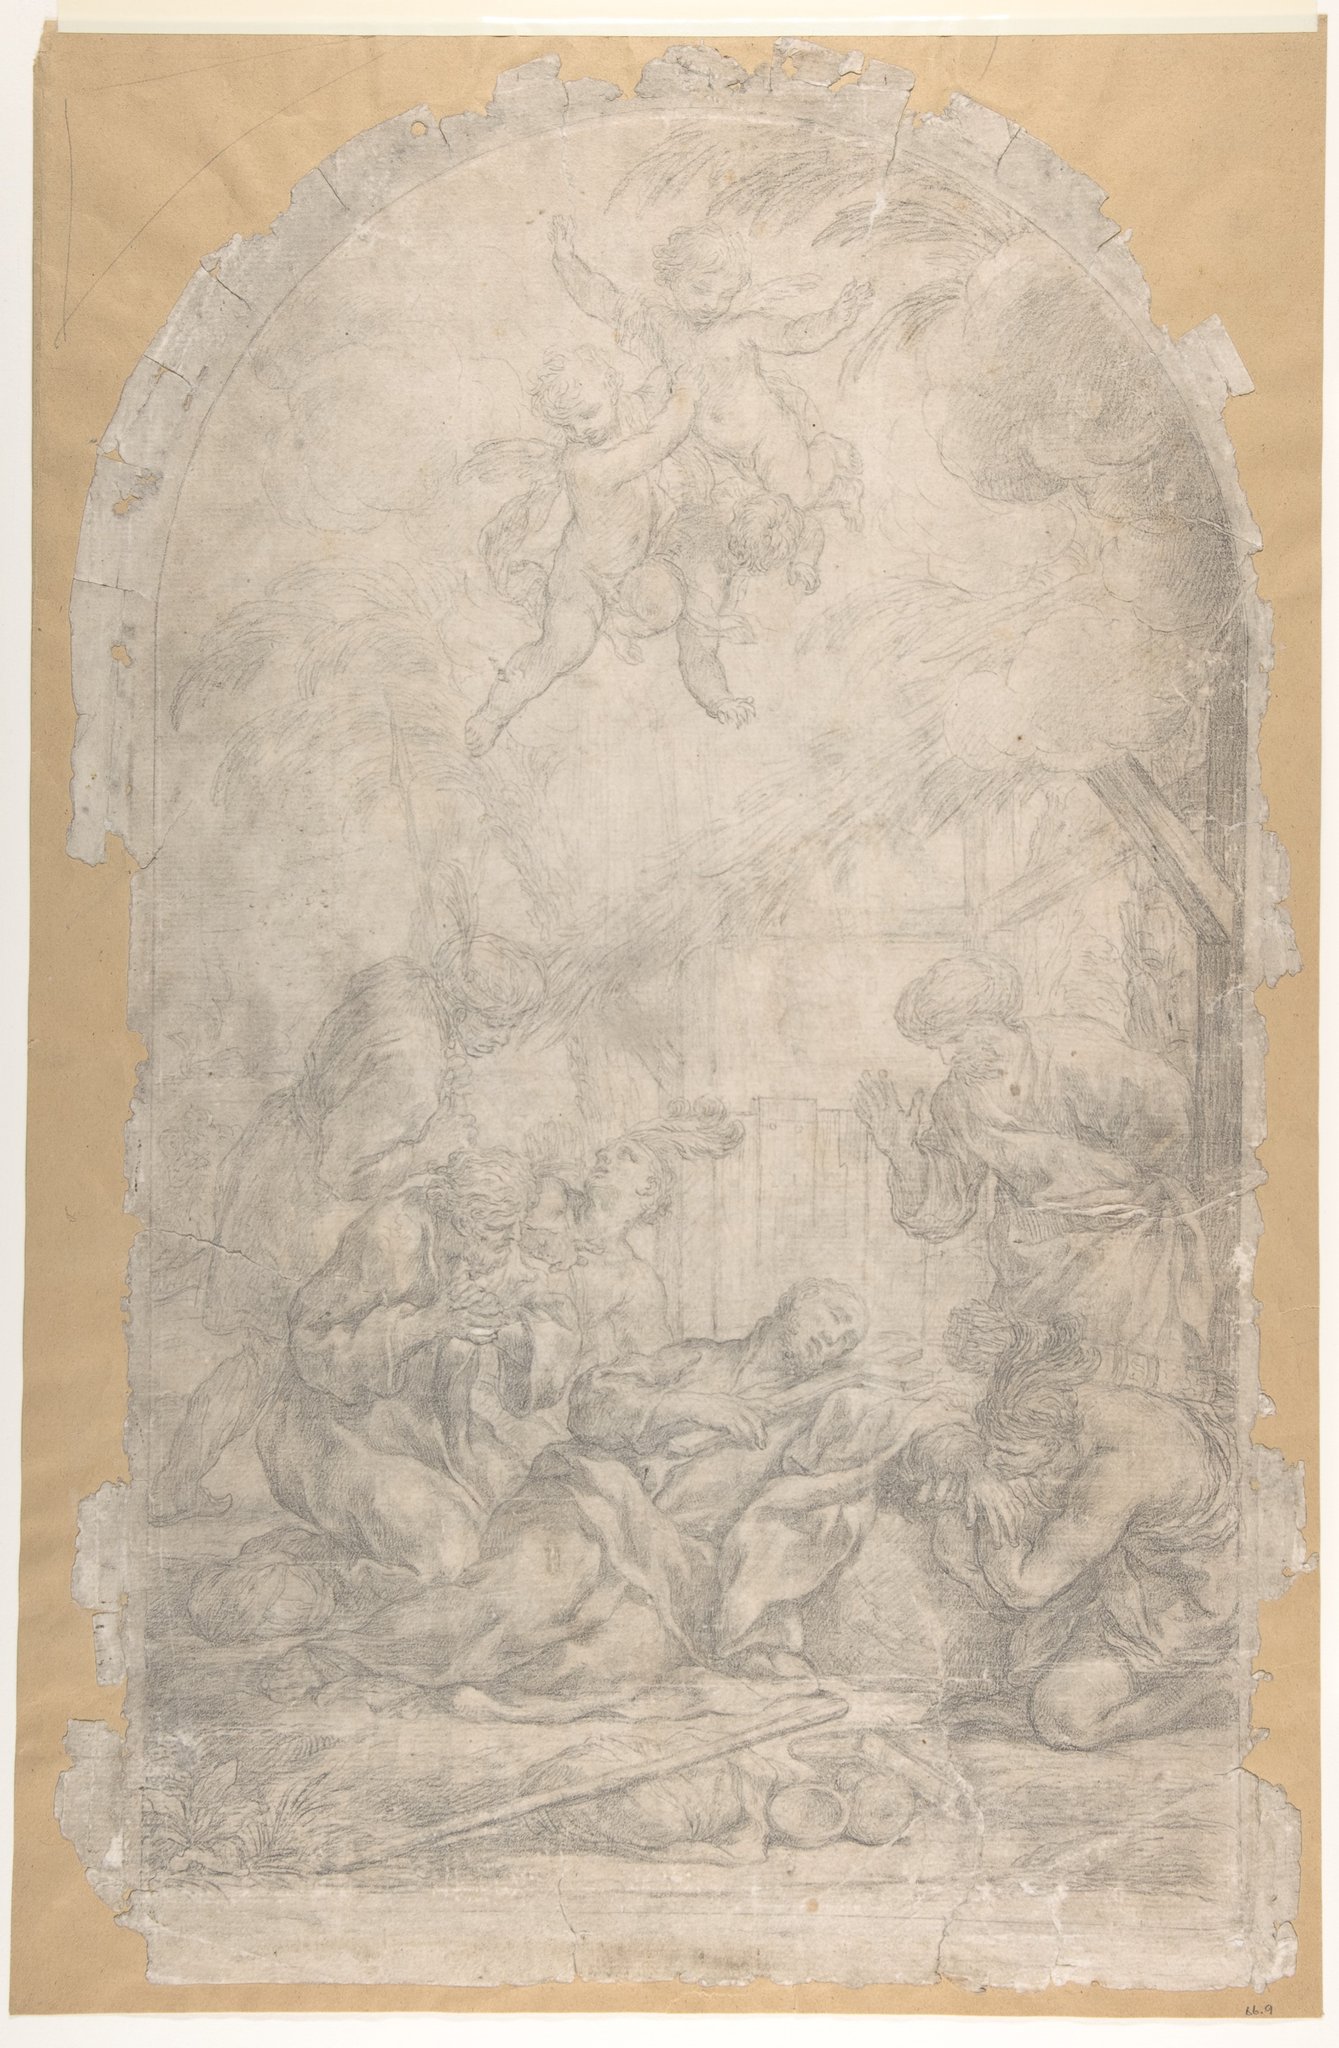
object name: drawing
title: The Death of Saint Francis Xavier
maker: ciro ferri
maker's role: artist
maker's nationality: italian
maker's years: 1634-1689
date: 1674-1679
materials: chalk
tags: saint francis,death